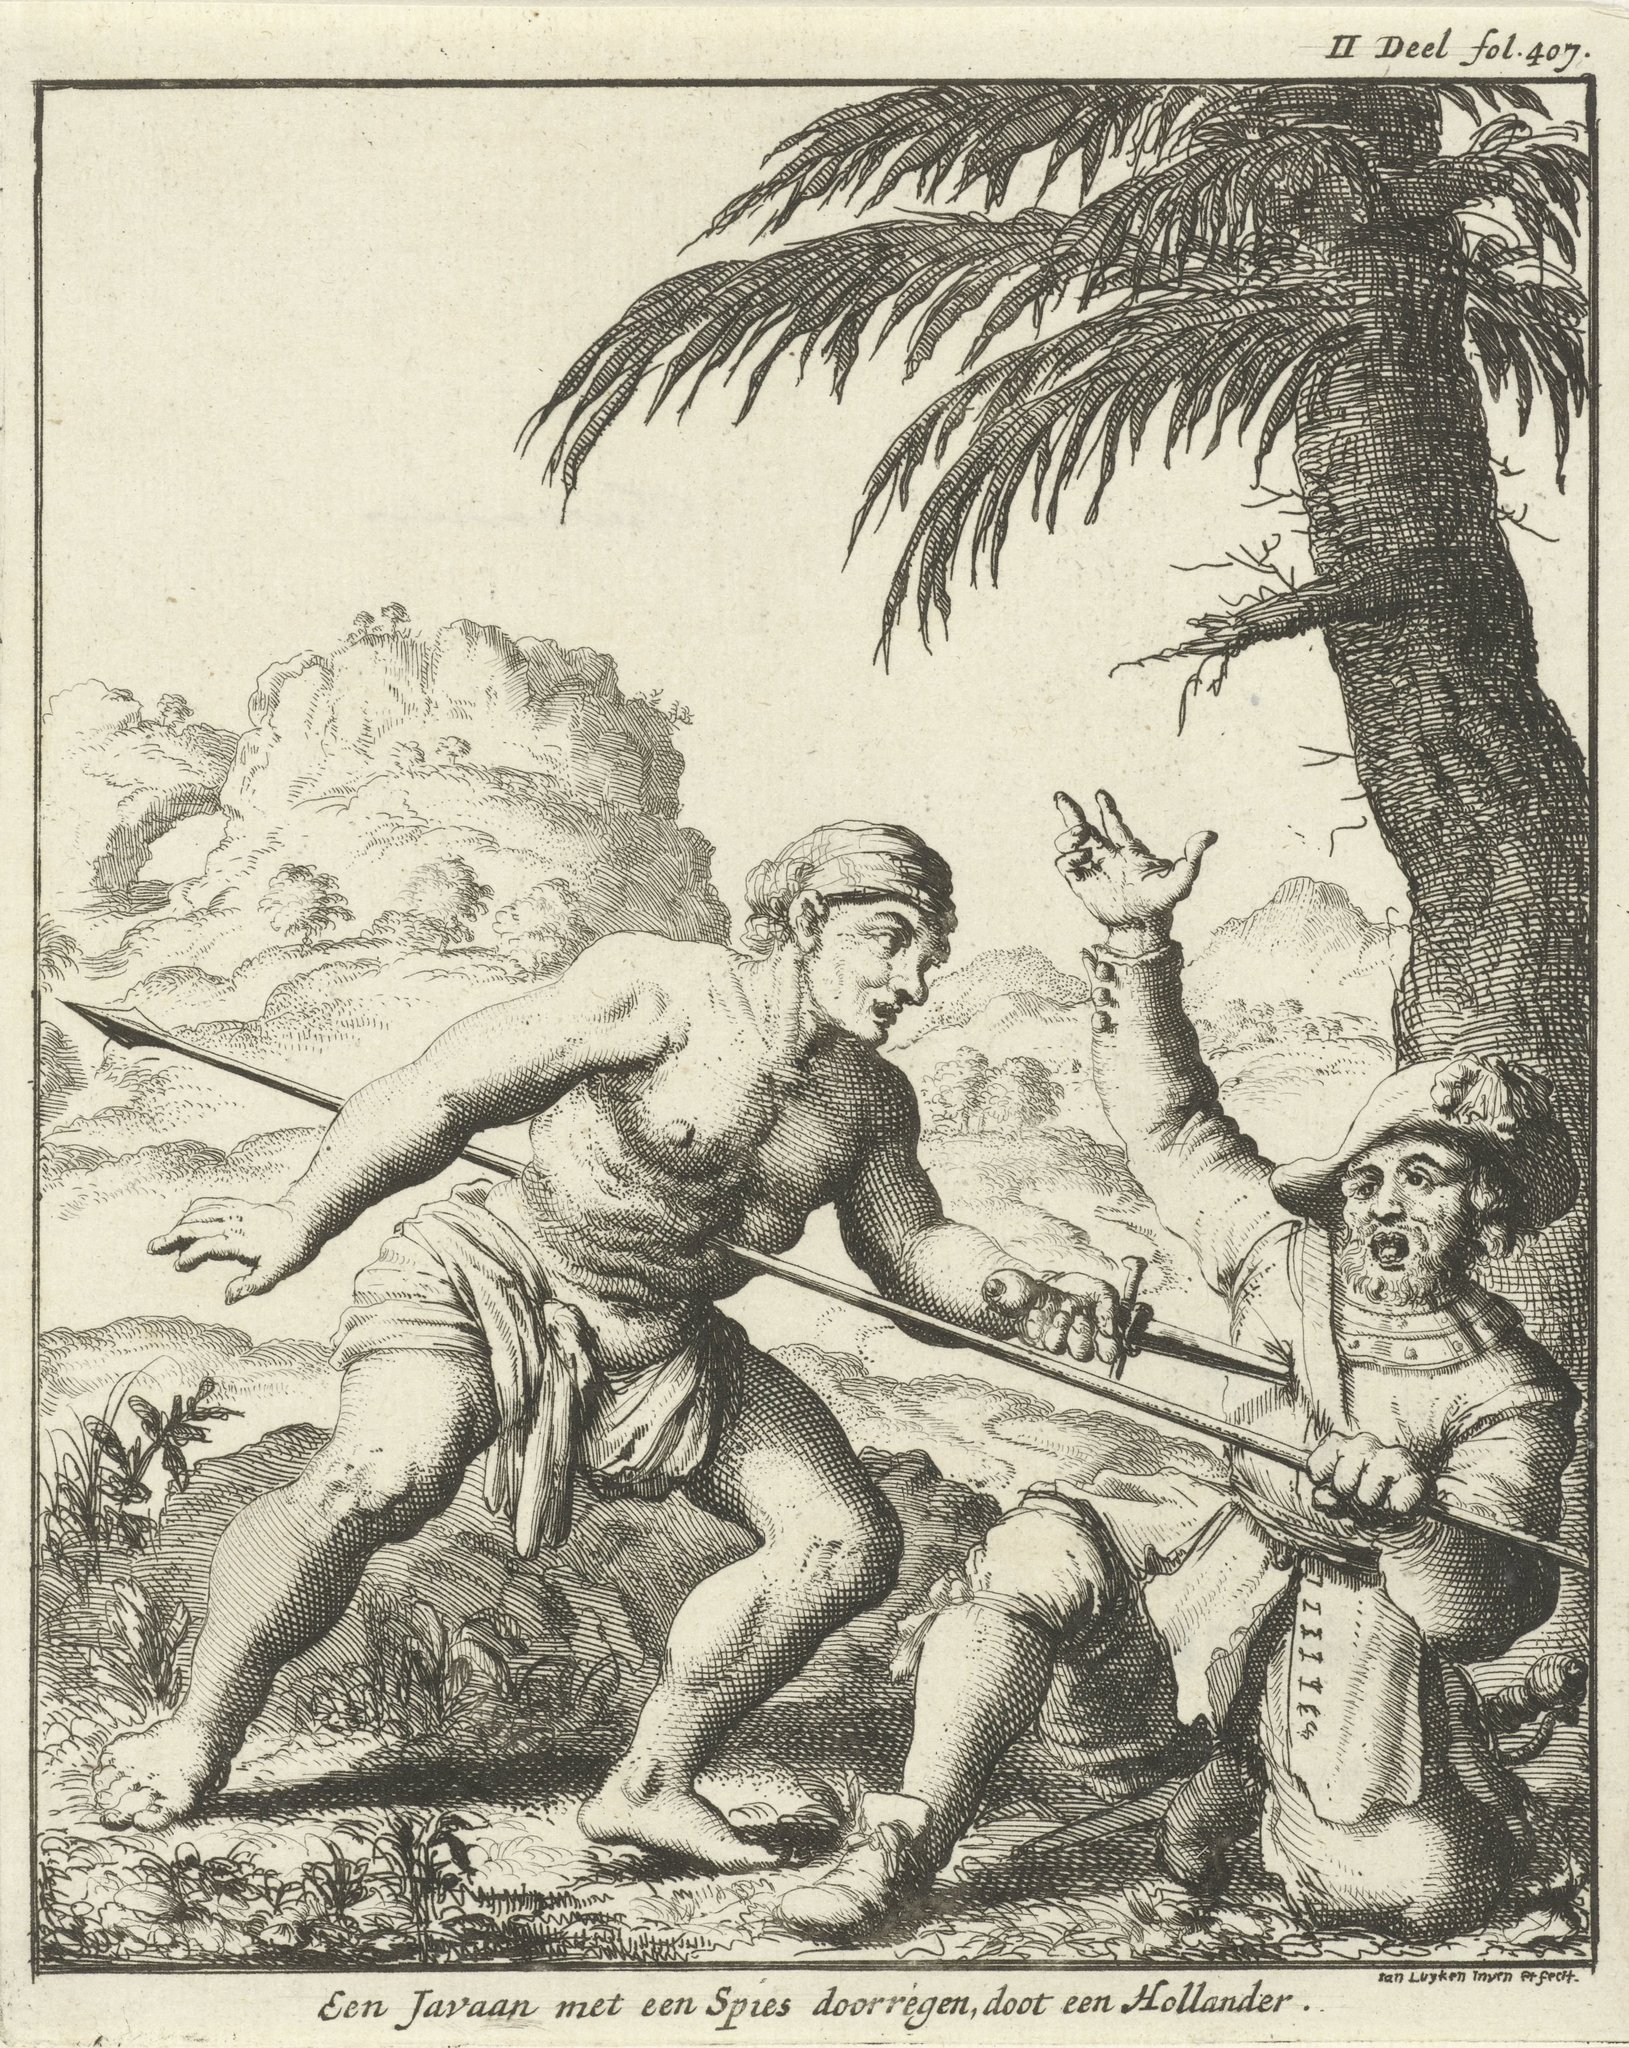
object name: print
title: Javaan en Hollander steken elkaar met een speer en een dolk neer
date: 1682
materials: paper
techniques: etching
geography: amsterdam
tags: violent death by cleaving and striking weapons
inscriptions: collector's mark: Lugt 2228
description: Illustratie opgenomen in: Tavernier, Jean Baptiste. De Zes Reizen, 3 delen. Amsterdam: weduwe Joannes van Someren, 1682, dl. 2.